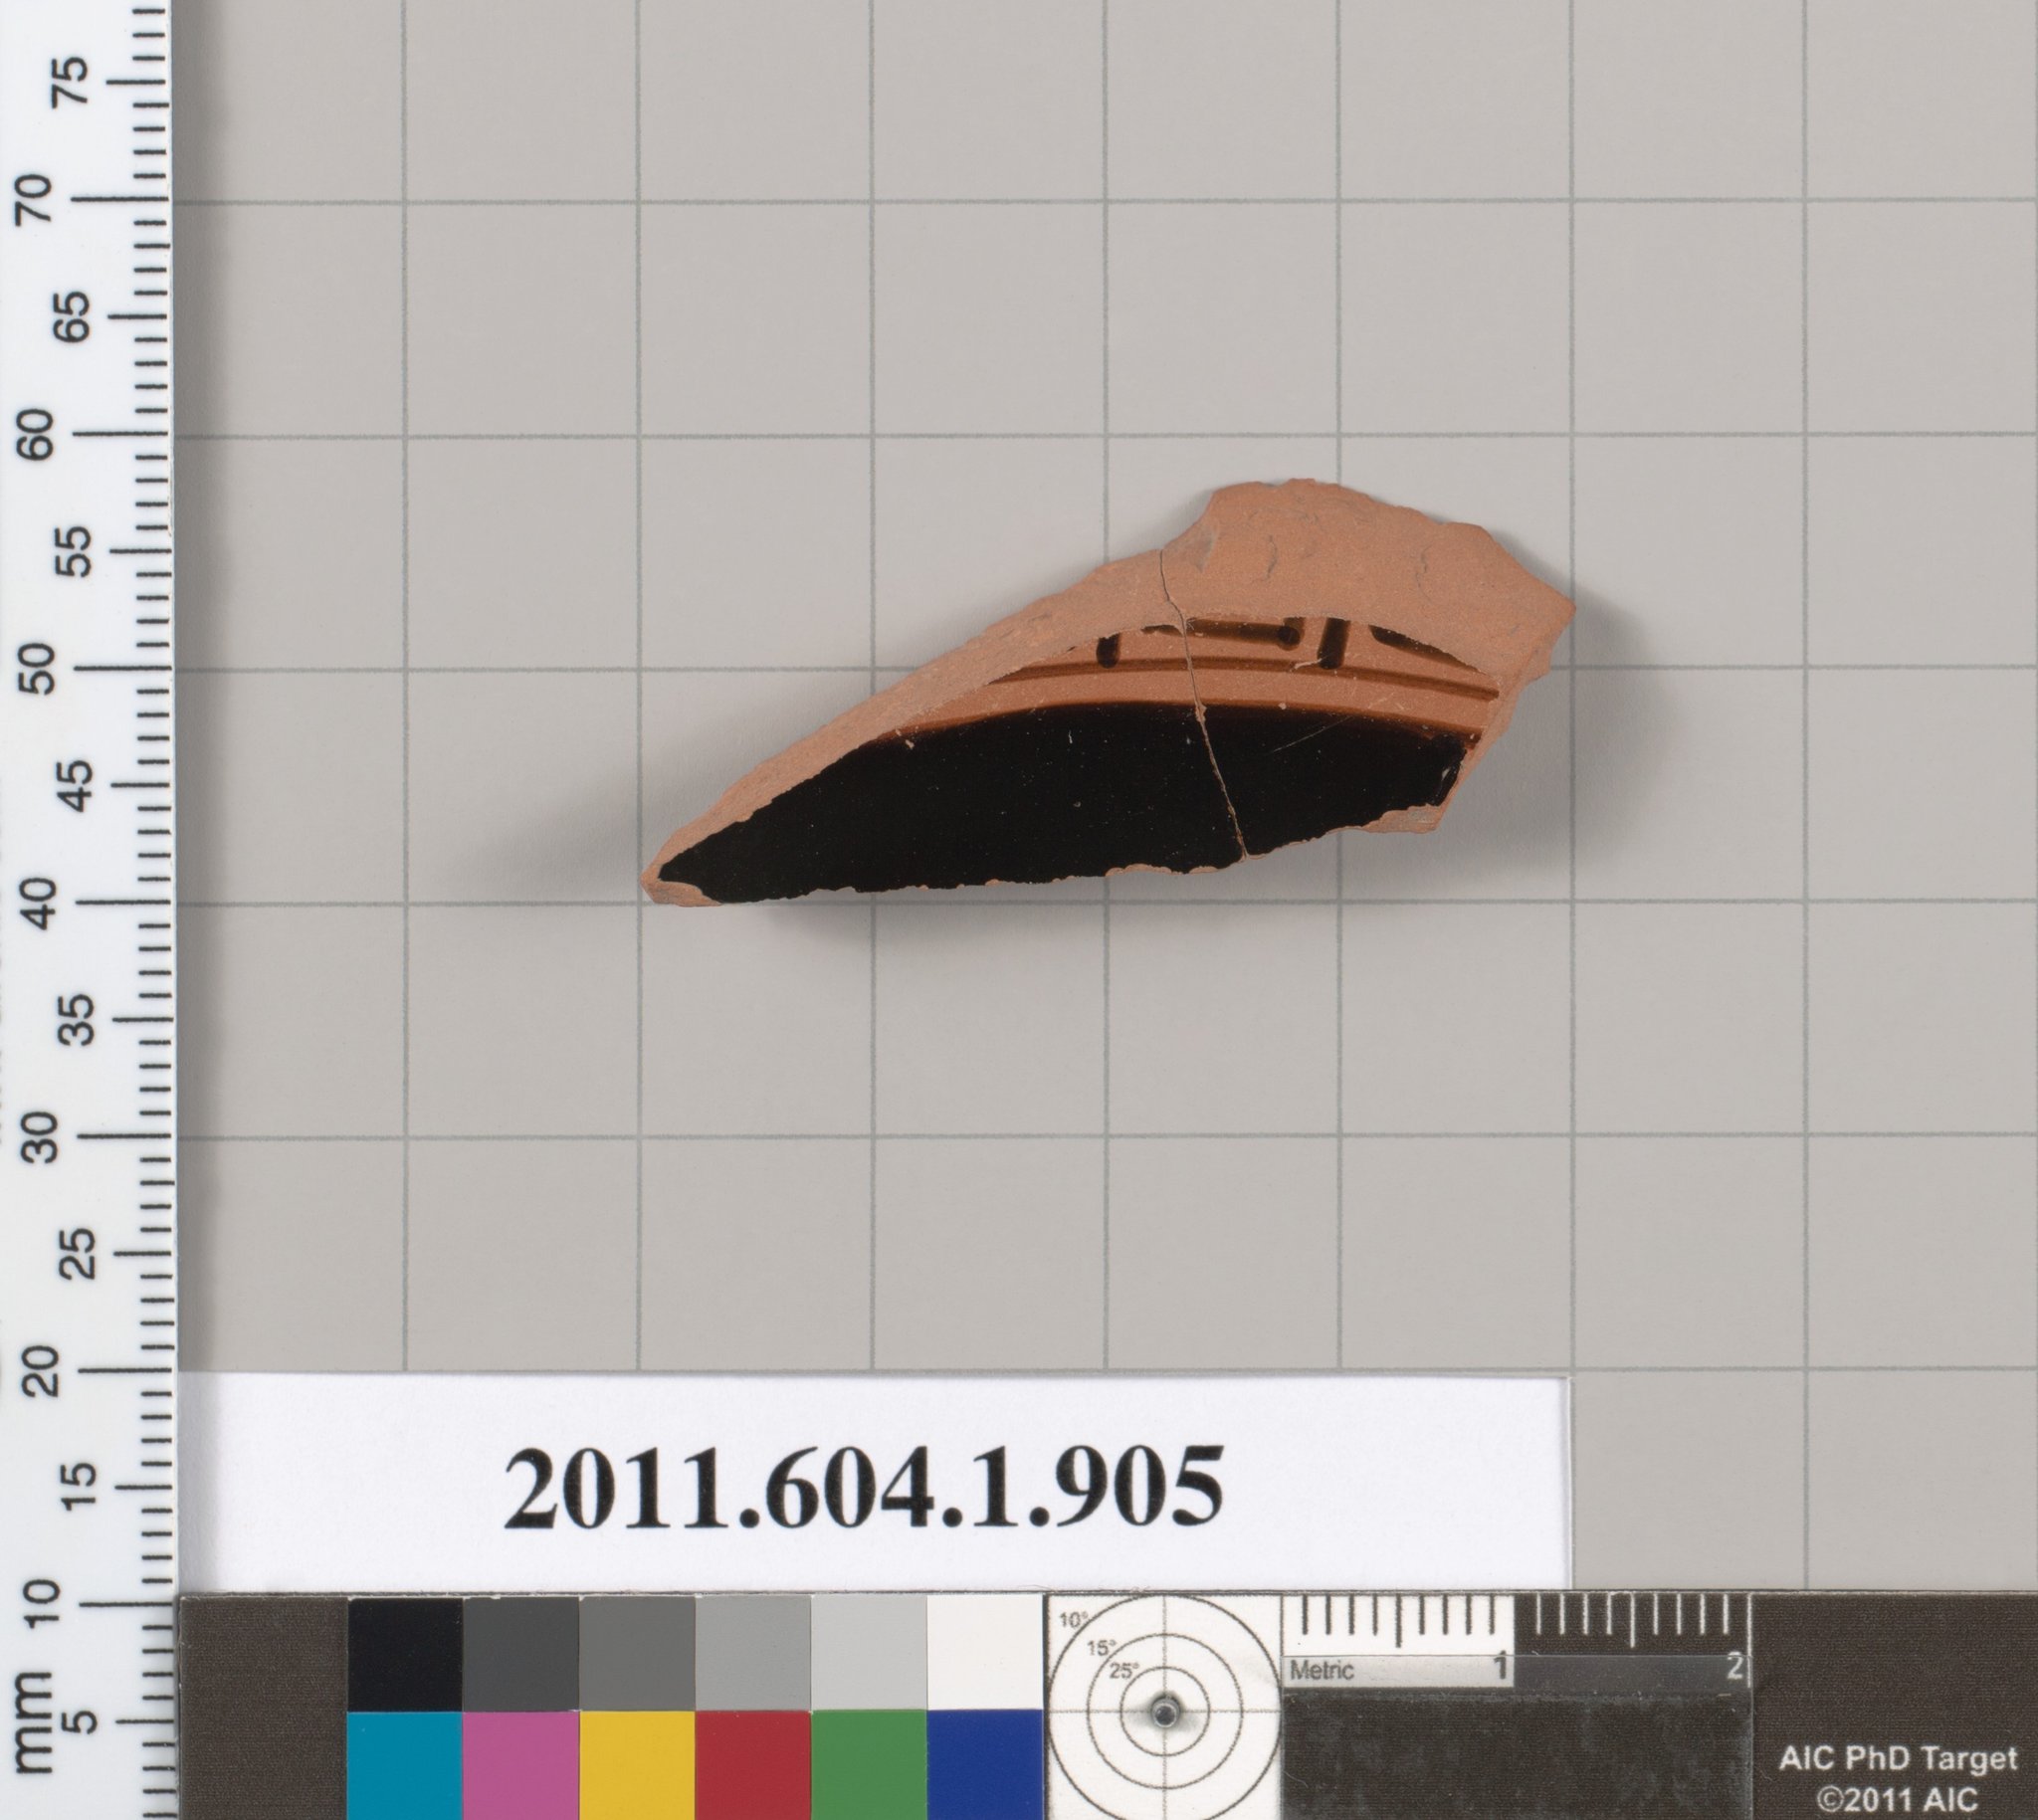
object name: kylix fragment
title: Terracotta fragment of a kylix (drinking cup)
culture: greek, attic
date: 490-480 BCE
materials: terracotta